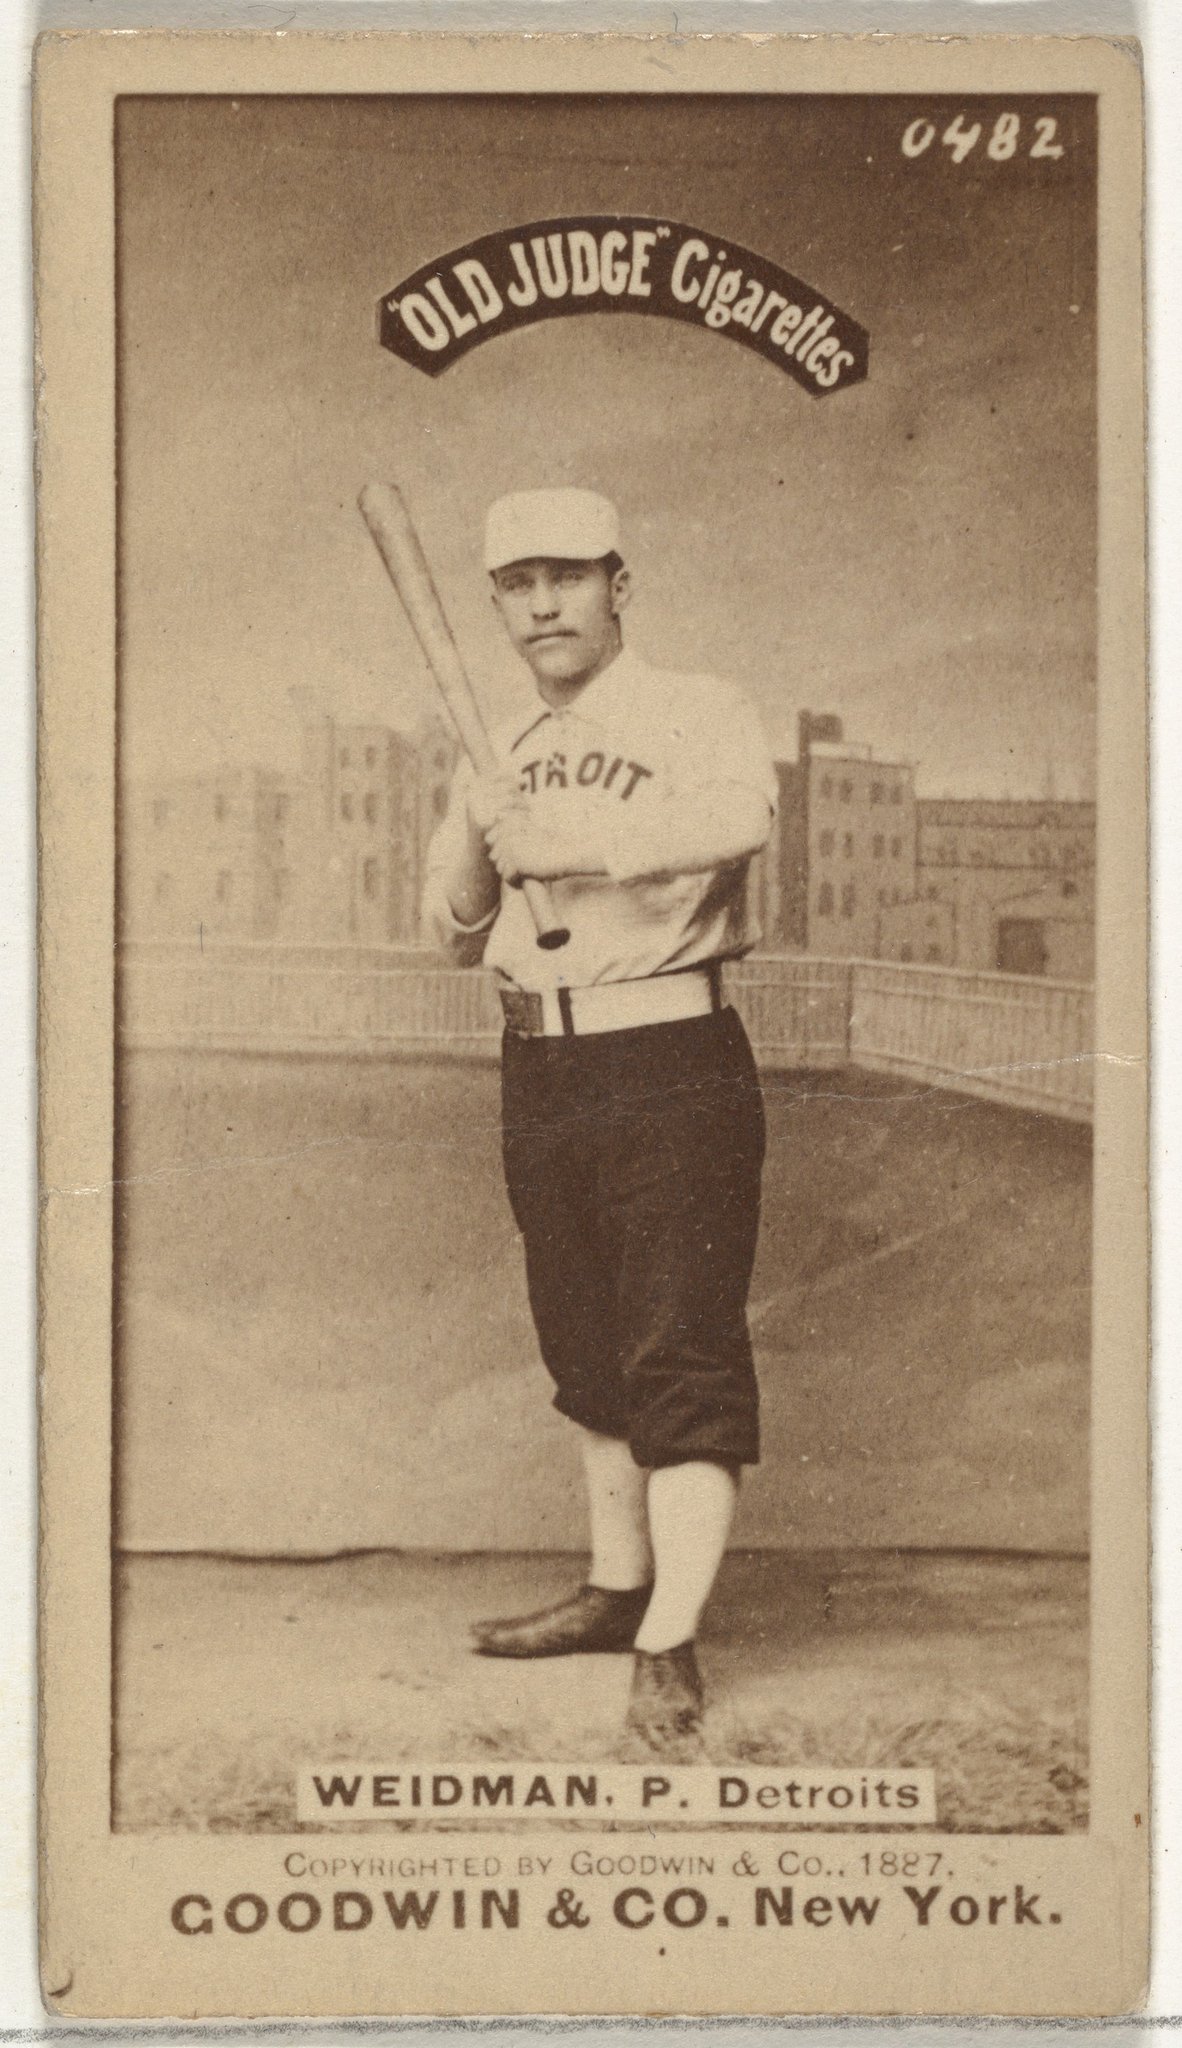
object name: baseball card, photograph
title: George Edward "Stump" Wiedman, Pitcher, Detroit Wolverines, from the Old Judge series (N172) for Old Judge Cigarettes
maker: goodwin & company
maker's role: publisher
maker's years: 1850-1950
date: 1887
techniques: albumen silver print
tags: men,portraits,baseball,athletes